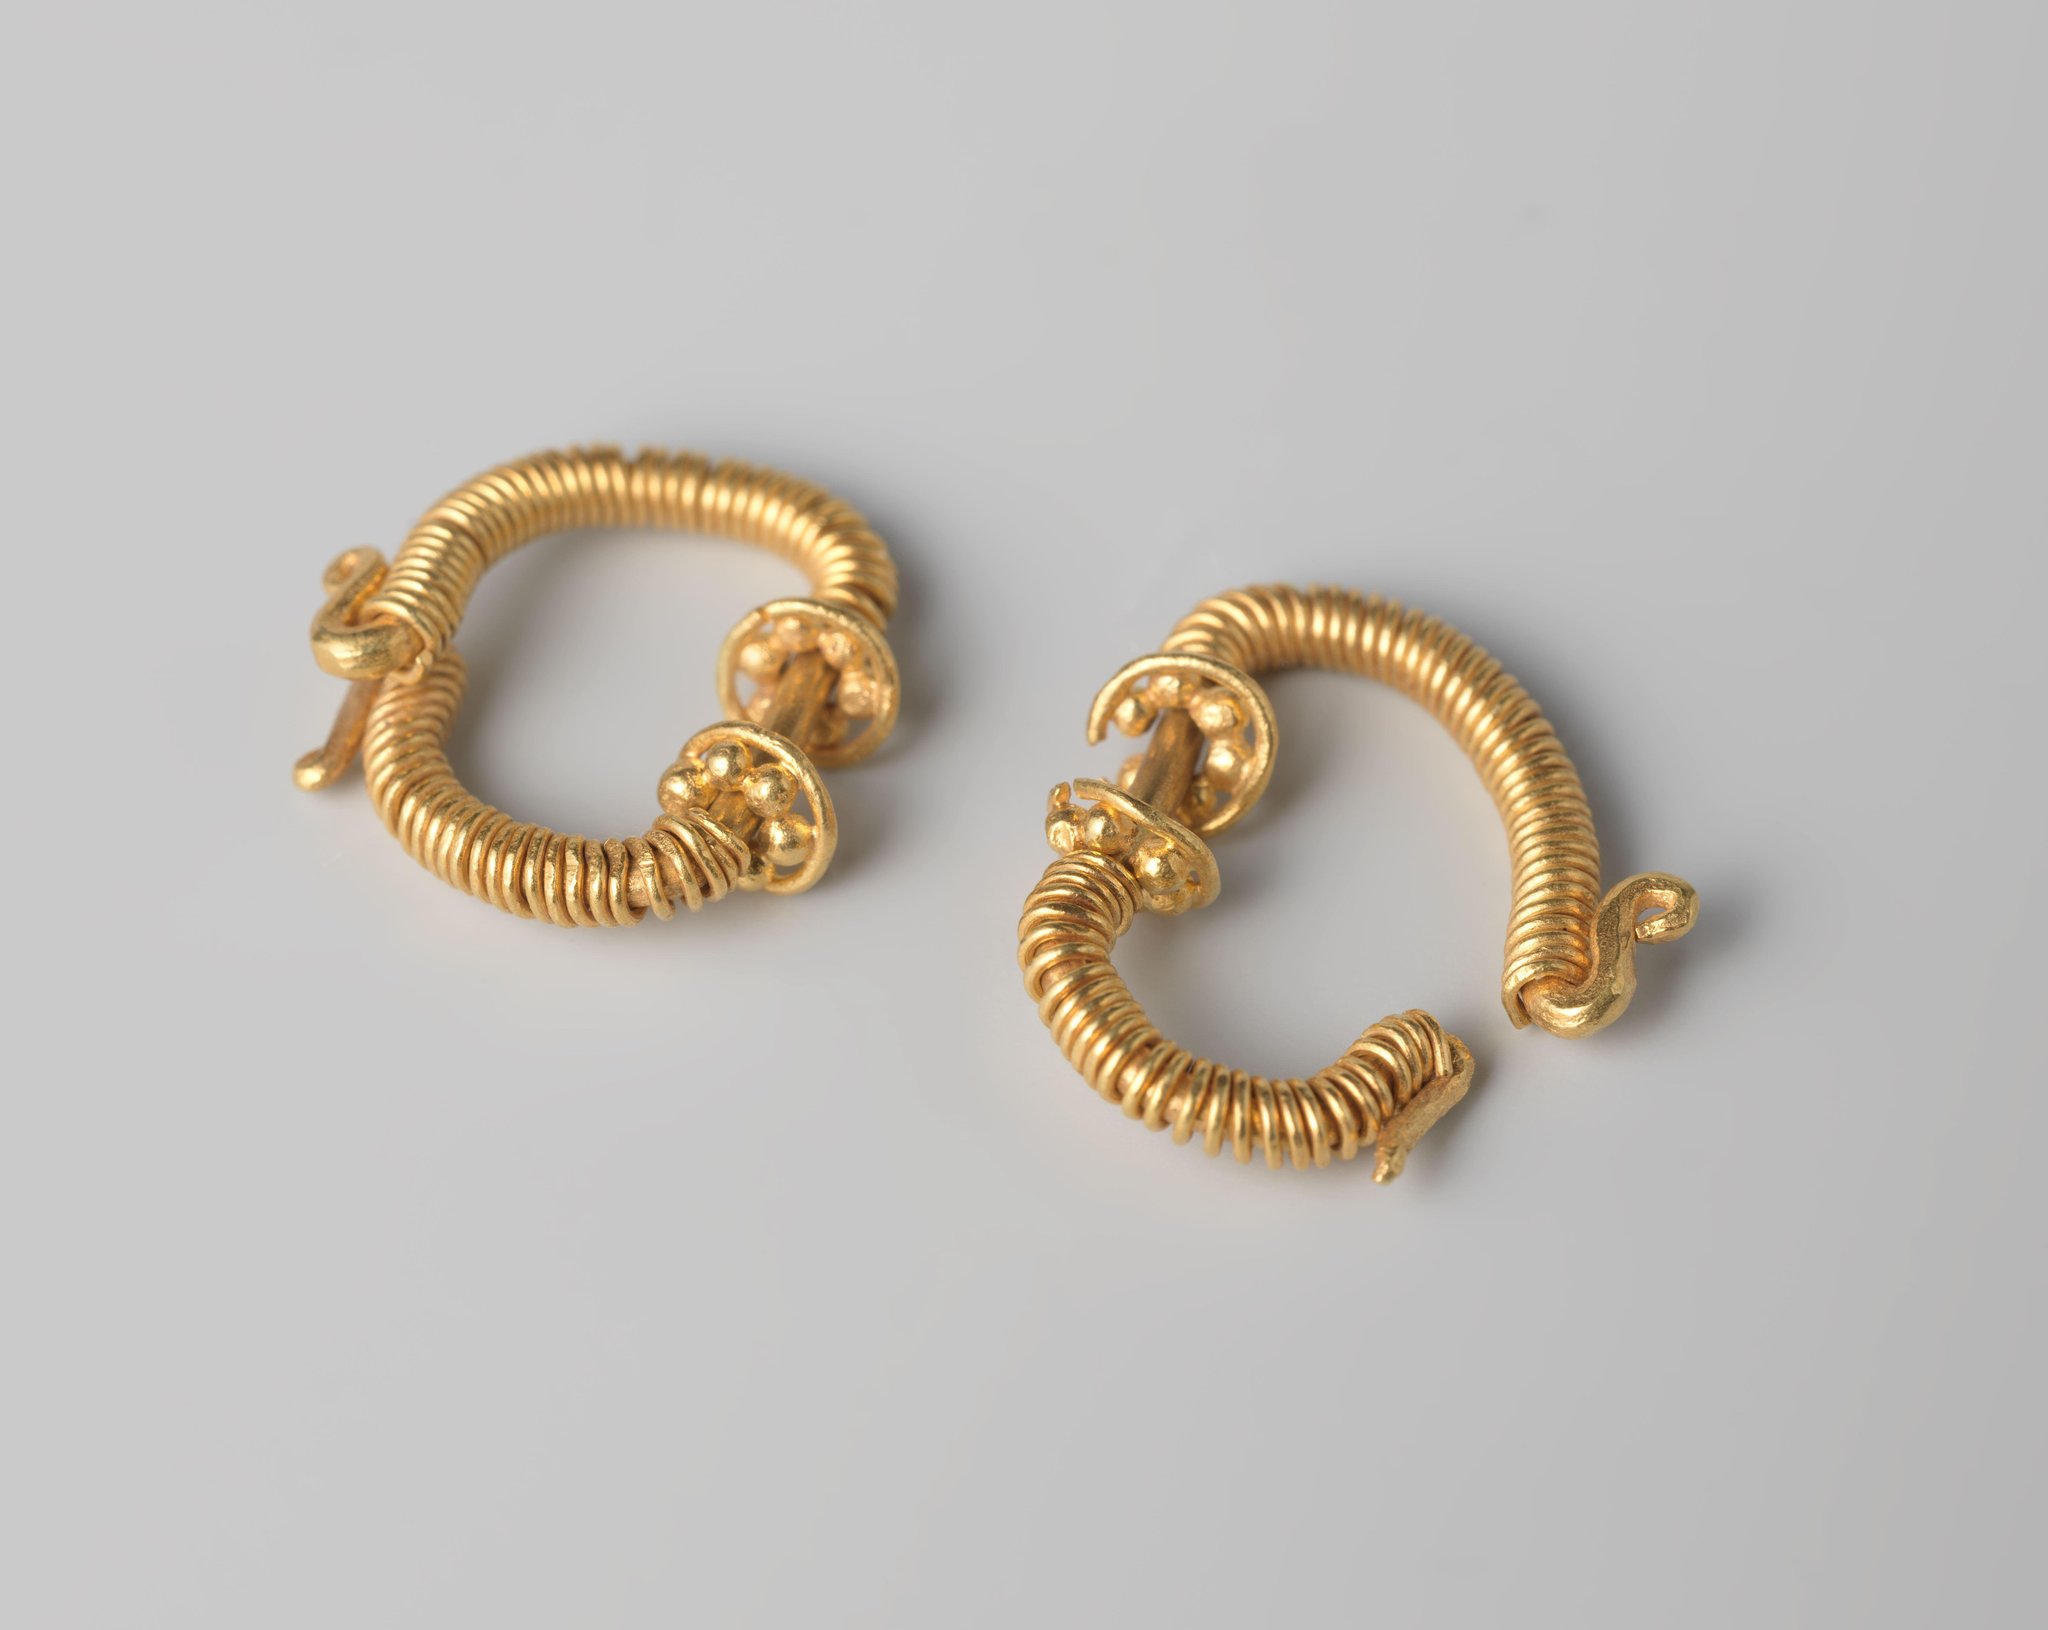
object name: ear ornament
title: Paar oorringen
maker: Anonymous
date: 300-600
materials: gold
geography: java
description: Een paar oorringen, samengesteld uit gewonden draad.